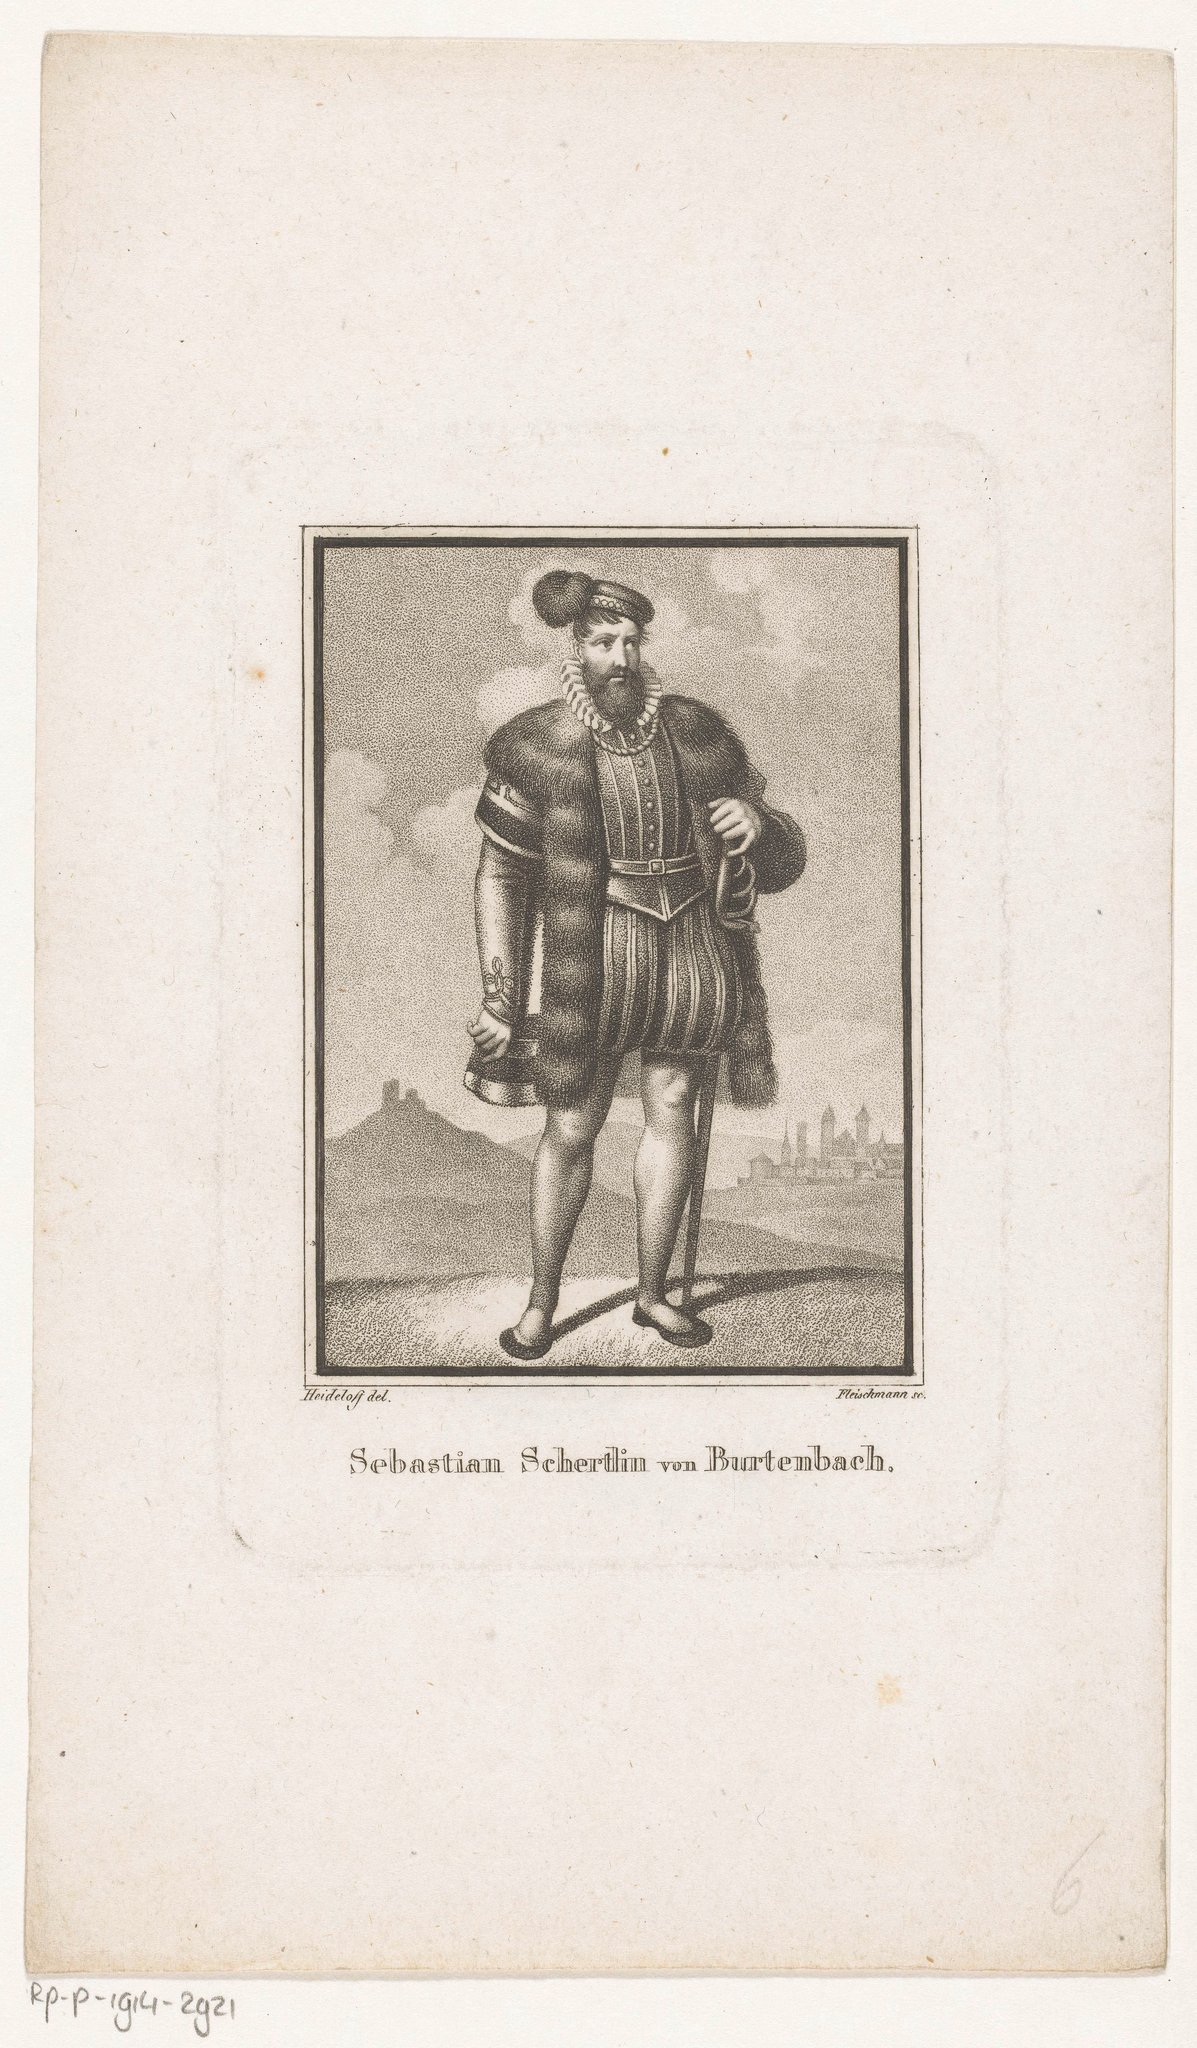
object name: print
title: Portret van Sebastian Schertlin von Burtenbach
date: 1801-1834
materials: paper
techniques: stippling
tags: landscapes, commander-in-chief, general, marshal, historical persons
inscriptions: collector's mark: Lugt 2228